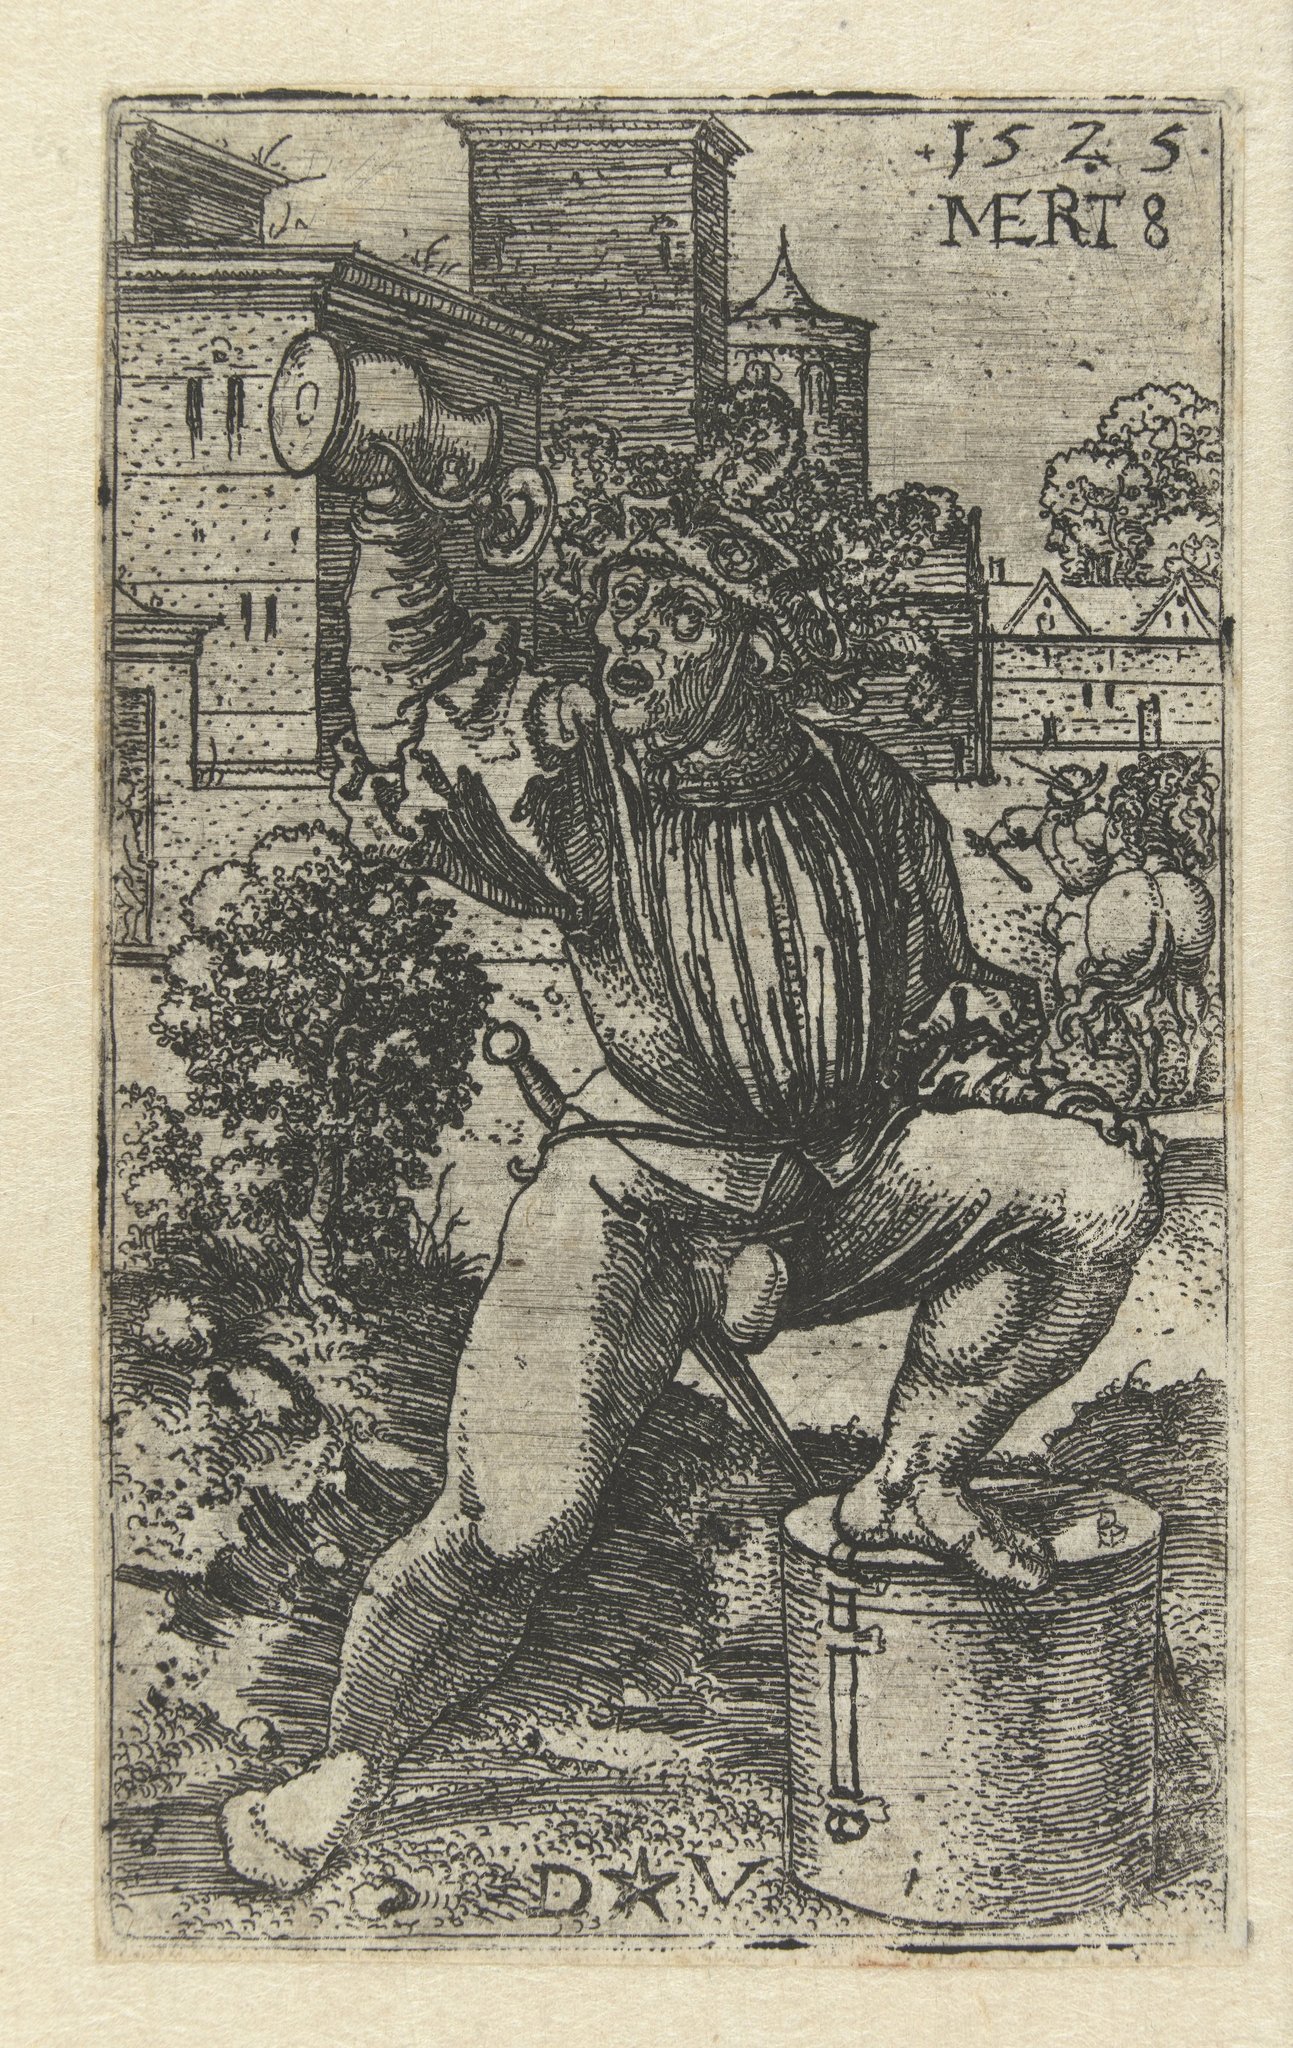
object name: print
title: De dronken tamboer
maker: dirck vellert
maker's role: draughtsman, painter, print maker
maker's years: 1480-1547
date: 1525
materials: paper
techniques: etching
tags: drum (musical instrument), drunkenness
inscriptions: collector's mark: Lugt 240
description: Trommelaar met linkervoet op trommel en in rechterhand kan met drank.